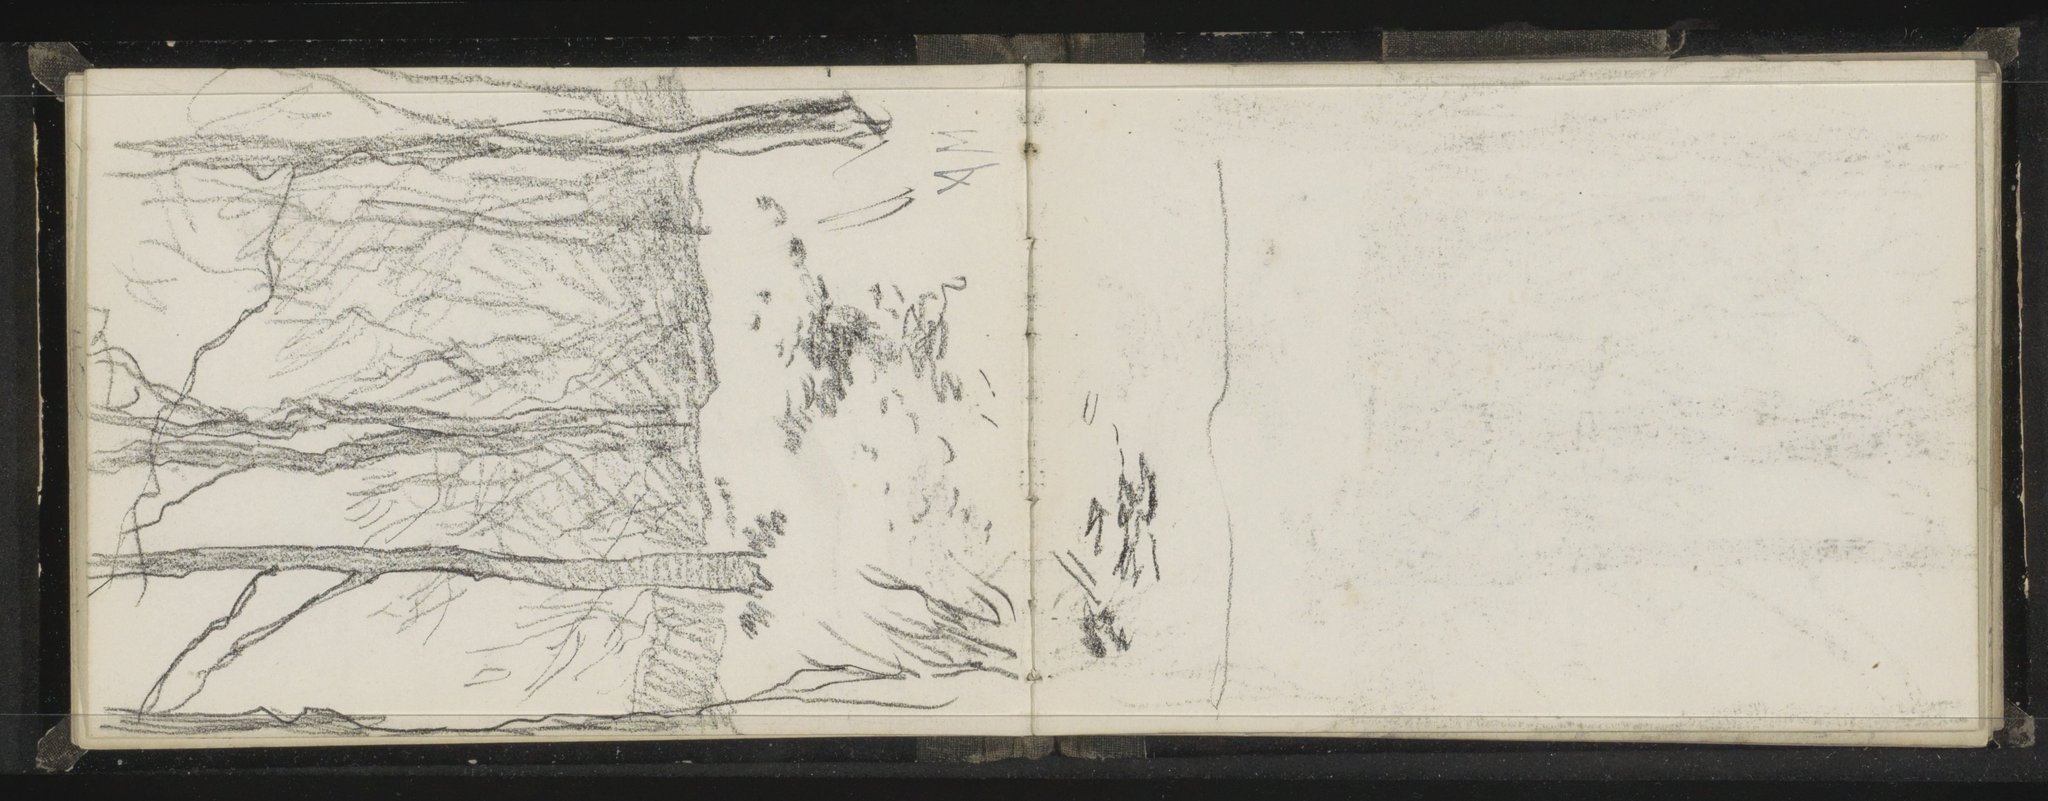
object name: sketchbook leaf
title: Open plek tussen de bomen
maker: anton mauve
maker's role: draughtsman, painter, print maker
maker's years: 1838-1888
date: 1848-1888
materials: chalk, paper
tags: trees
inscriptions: monogram: ‘AM’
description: Blad 9 verso en 10 recto uit een schetsboek met 33 bladen.